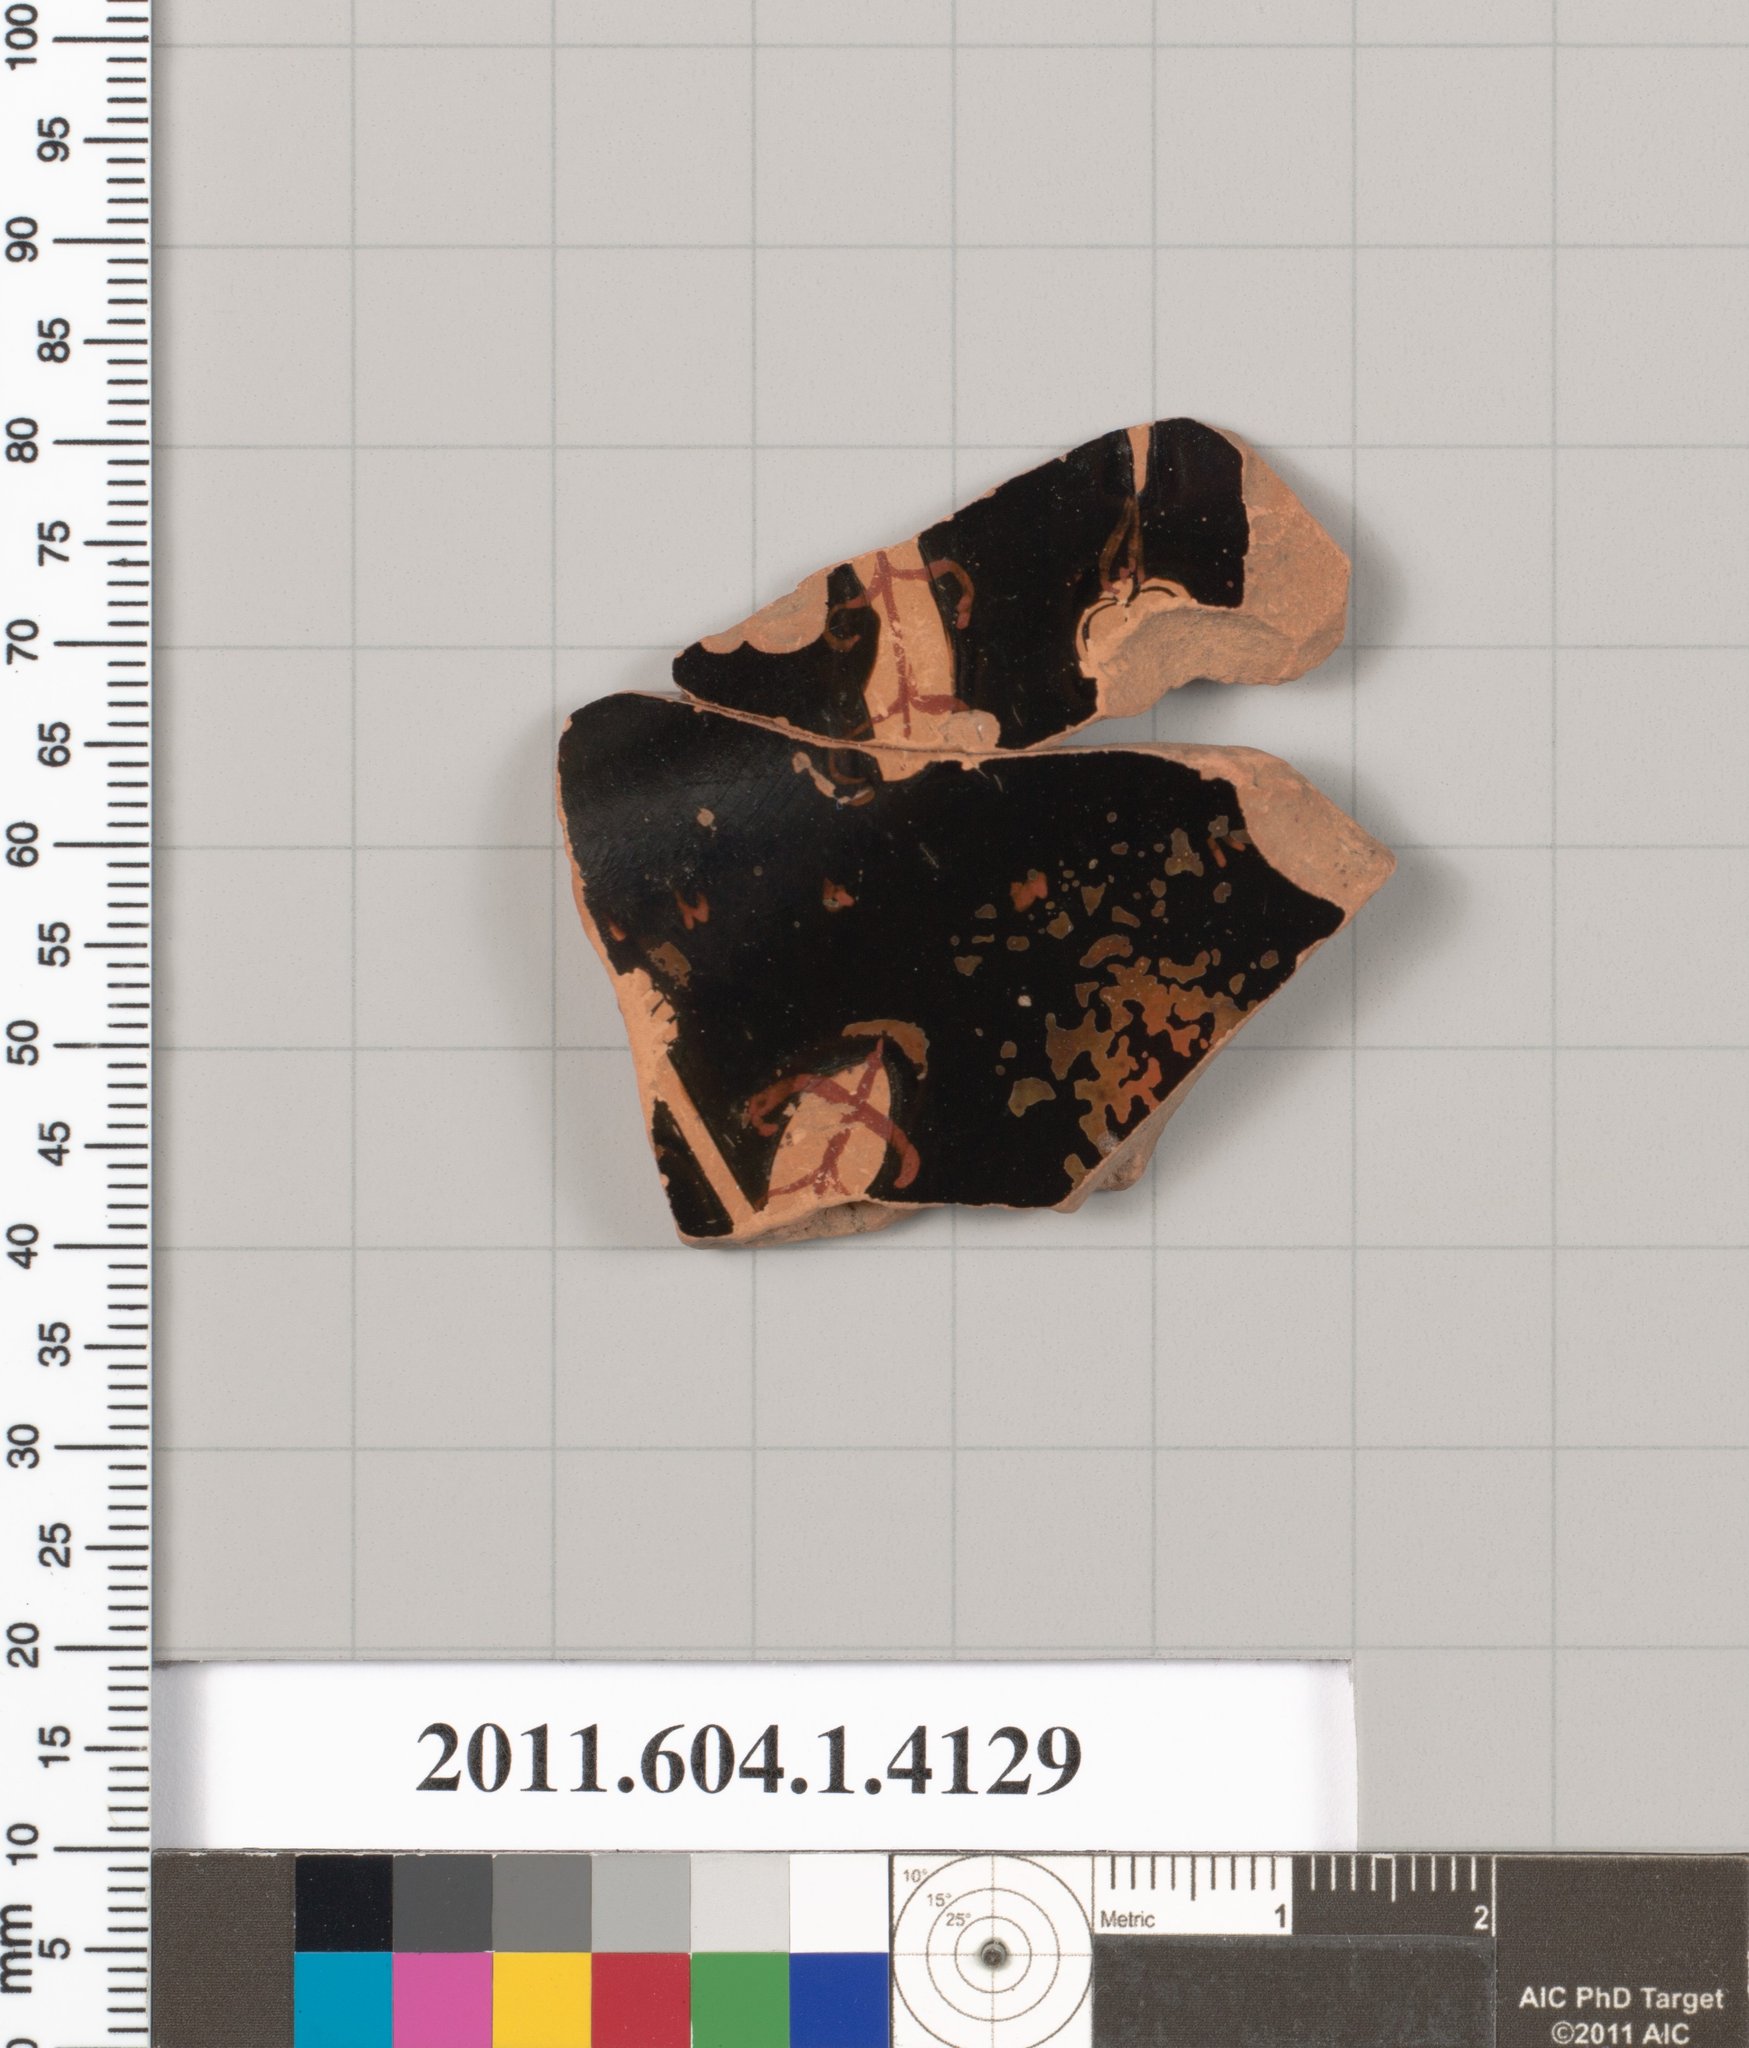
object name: kylix fragment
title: Terracotta fragment of a kylix (drinking cup)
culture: greek, attic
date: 490-470 BCE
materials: terracotta